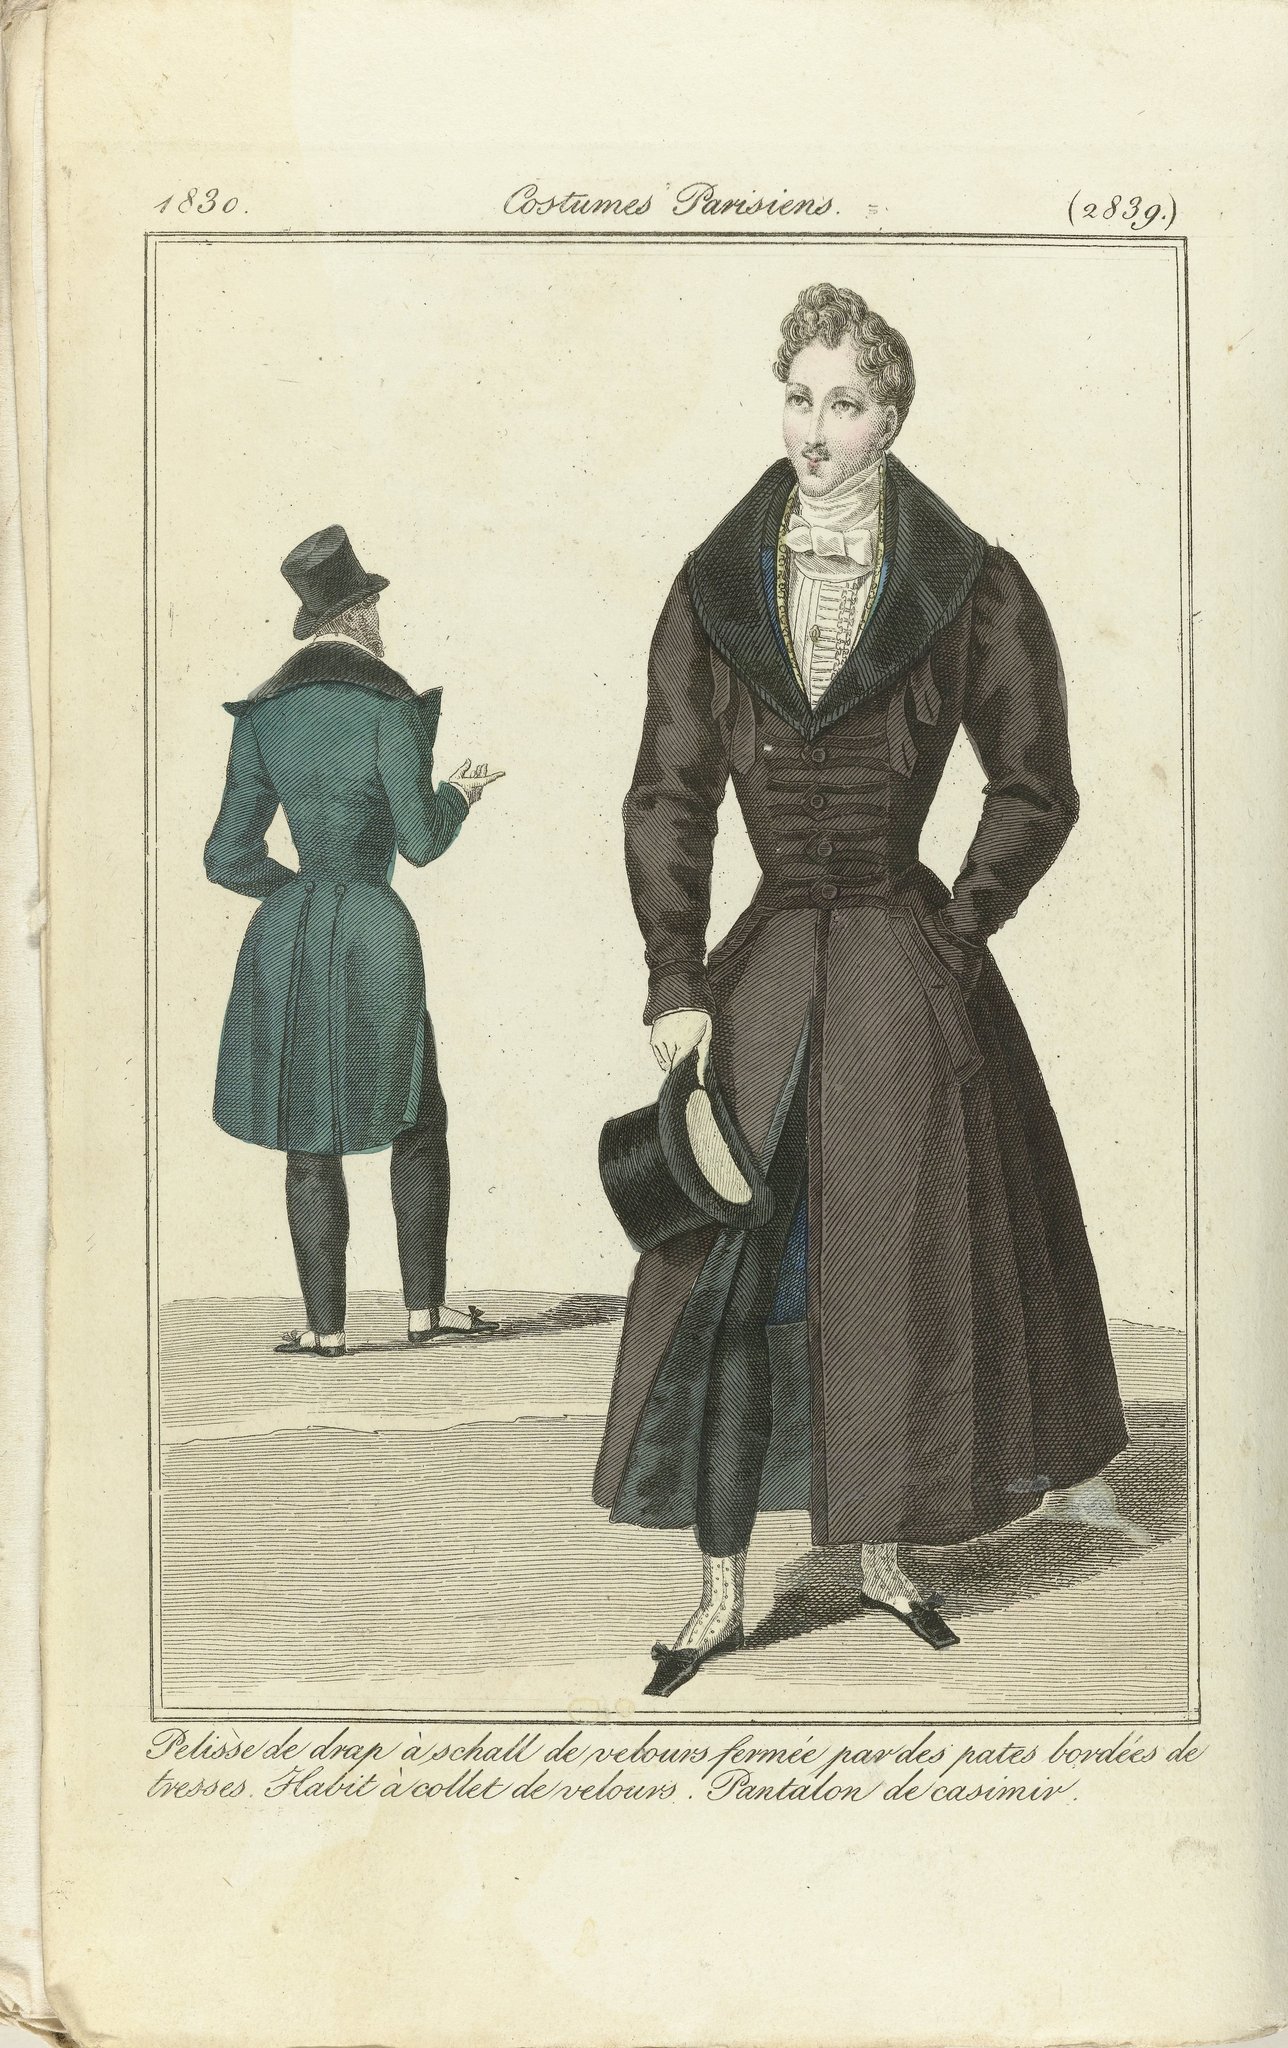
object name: fashion print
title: Journal des Dames et des Modes 1830, Costumes Parisiens (2839)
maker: Anonymous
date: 1830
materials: paper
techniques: etching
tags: coat (pelisse) (+ men's clothes), fashion plates, clothes, costume (+ men's clothes)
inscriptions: date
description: Pelisse de drap a schall de velours fermée par des pates bordées de tresses. Habit a collet de velours. Pantalon de casimir.